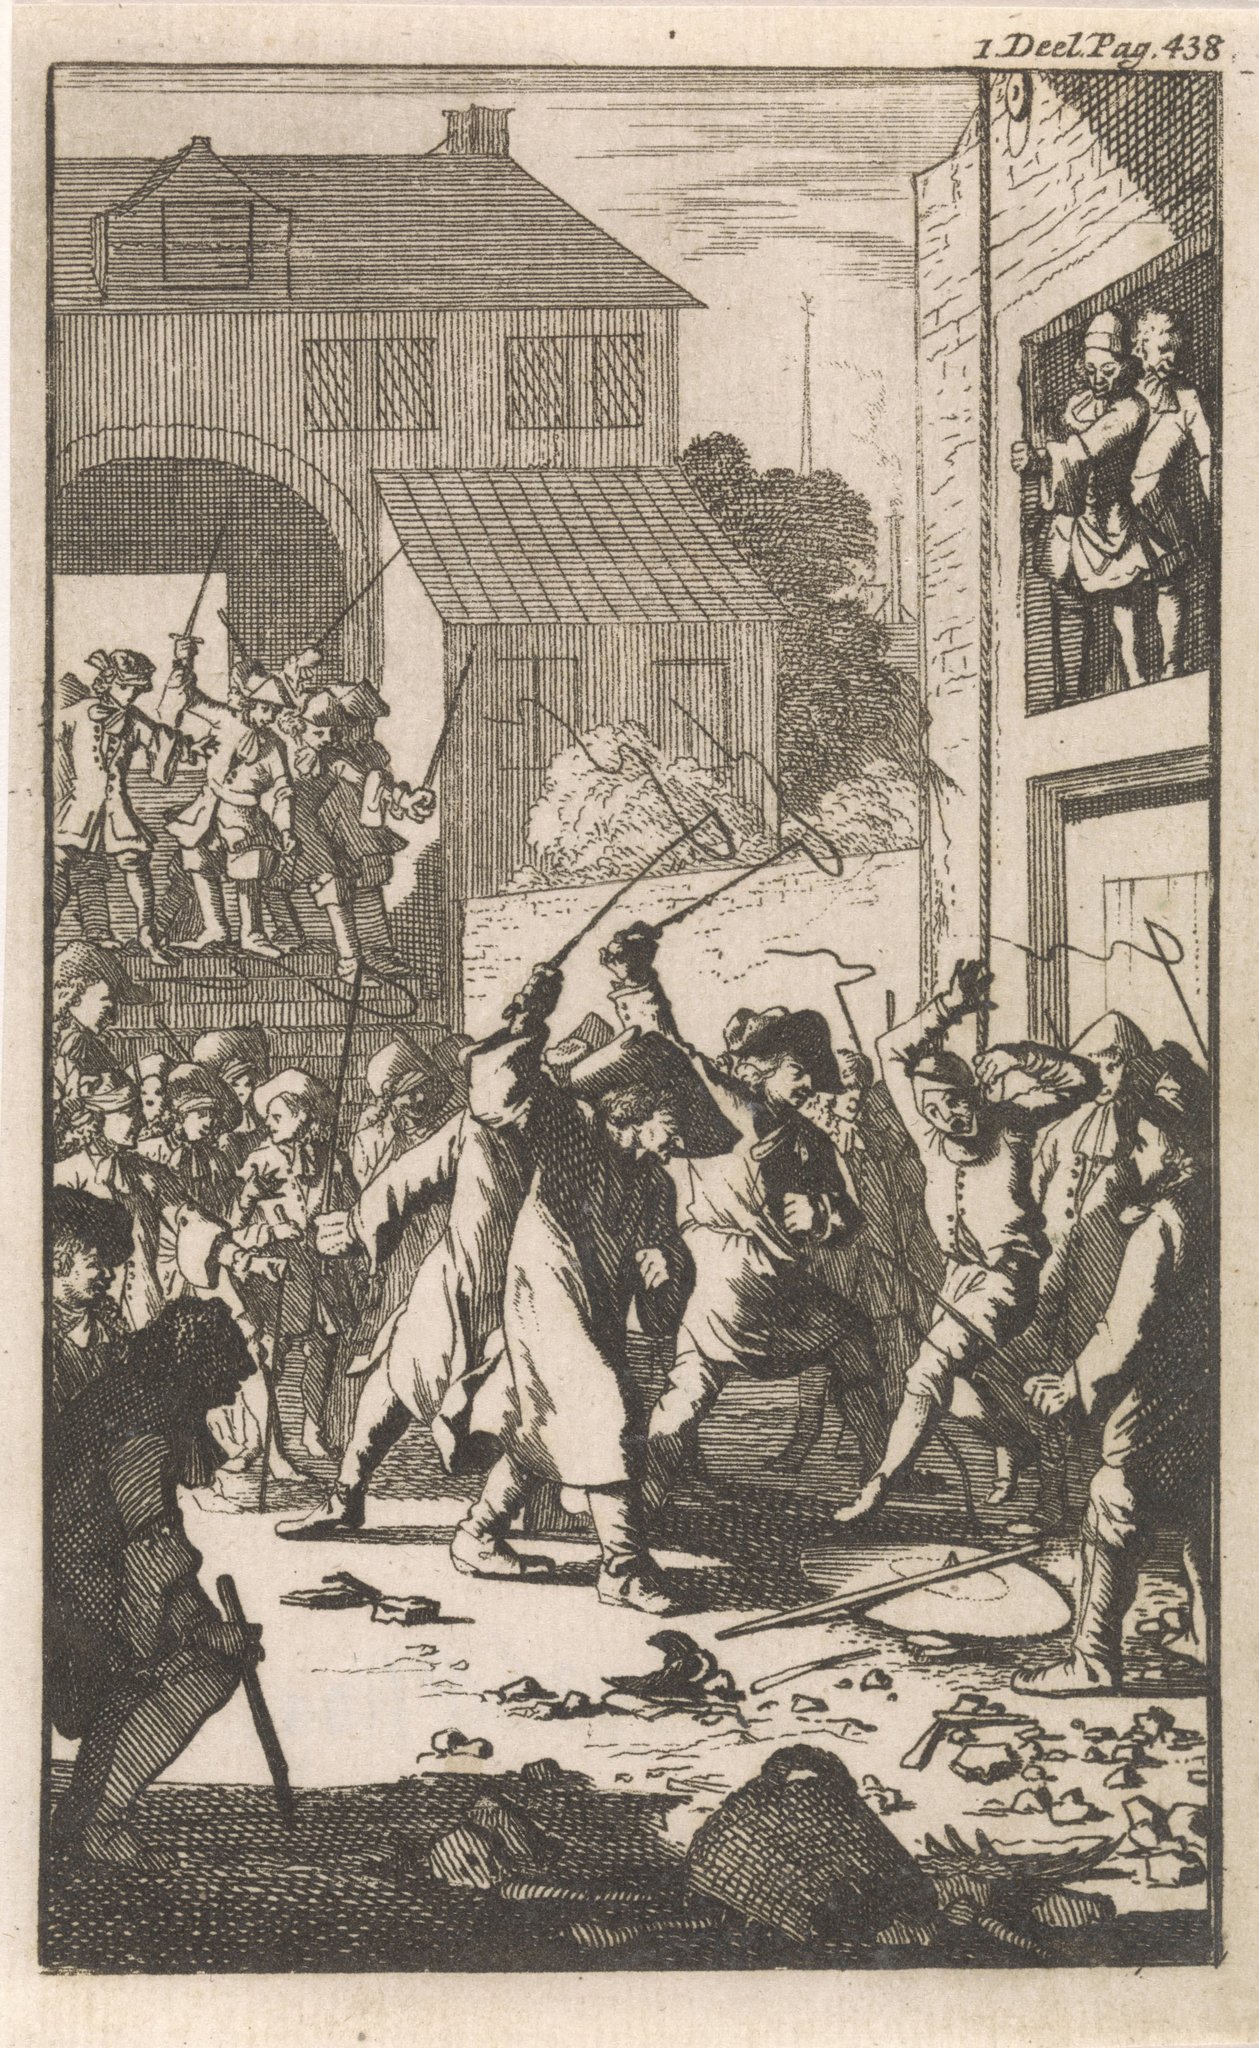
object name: book illustration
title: Don Clarazel mishandeld door koetsiers in een herberg nabij Toulon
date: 1697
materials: paper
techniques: etching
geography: amsterdam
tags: flogging, scourging (in public)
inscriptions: collector's mark: Lugt 2228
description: Illustratie uit: Verdier, Gilbert Saulnier du (vert. Heinsius, Nicolaas junior). Don Clarazel de Gontarnos, ofte den buiten-spoorigen dolenden ridder, 2 delen. Amsterdam: Johannes Broersz en Nathanael Holbeex, 1697, dl. 1.